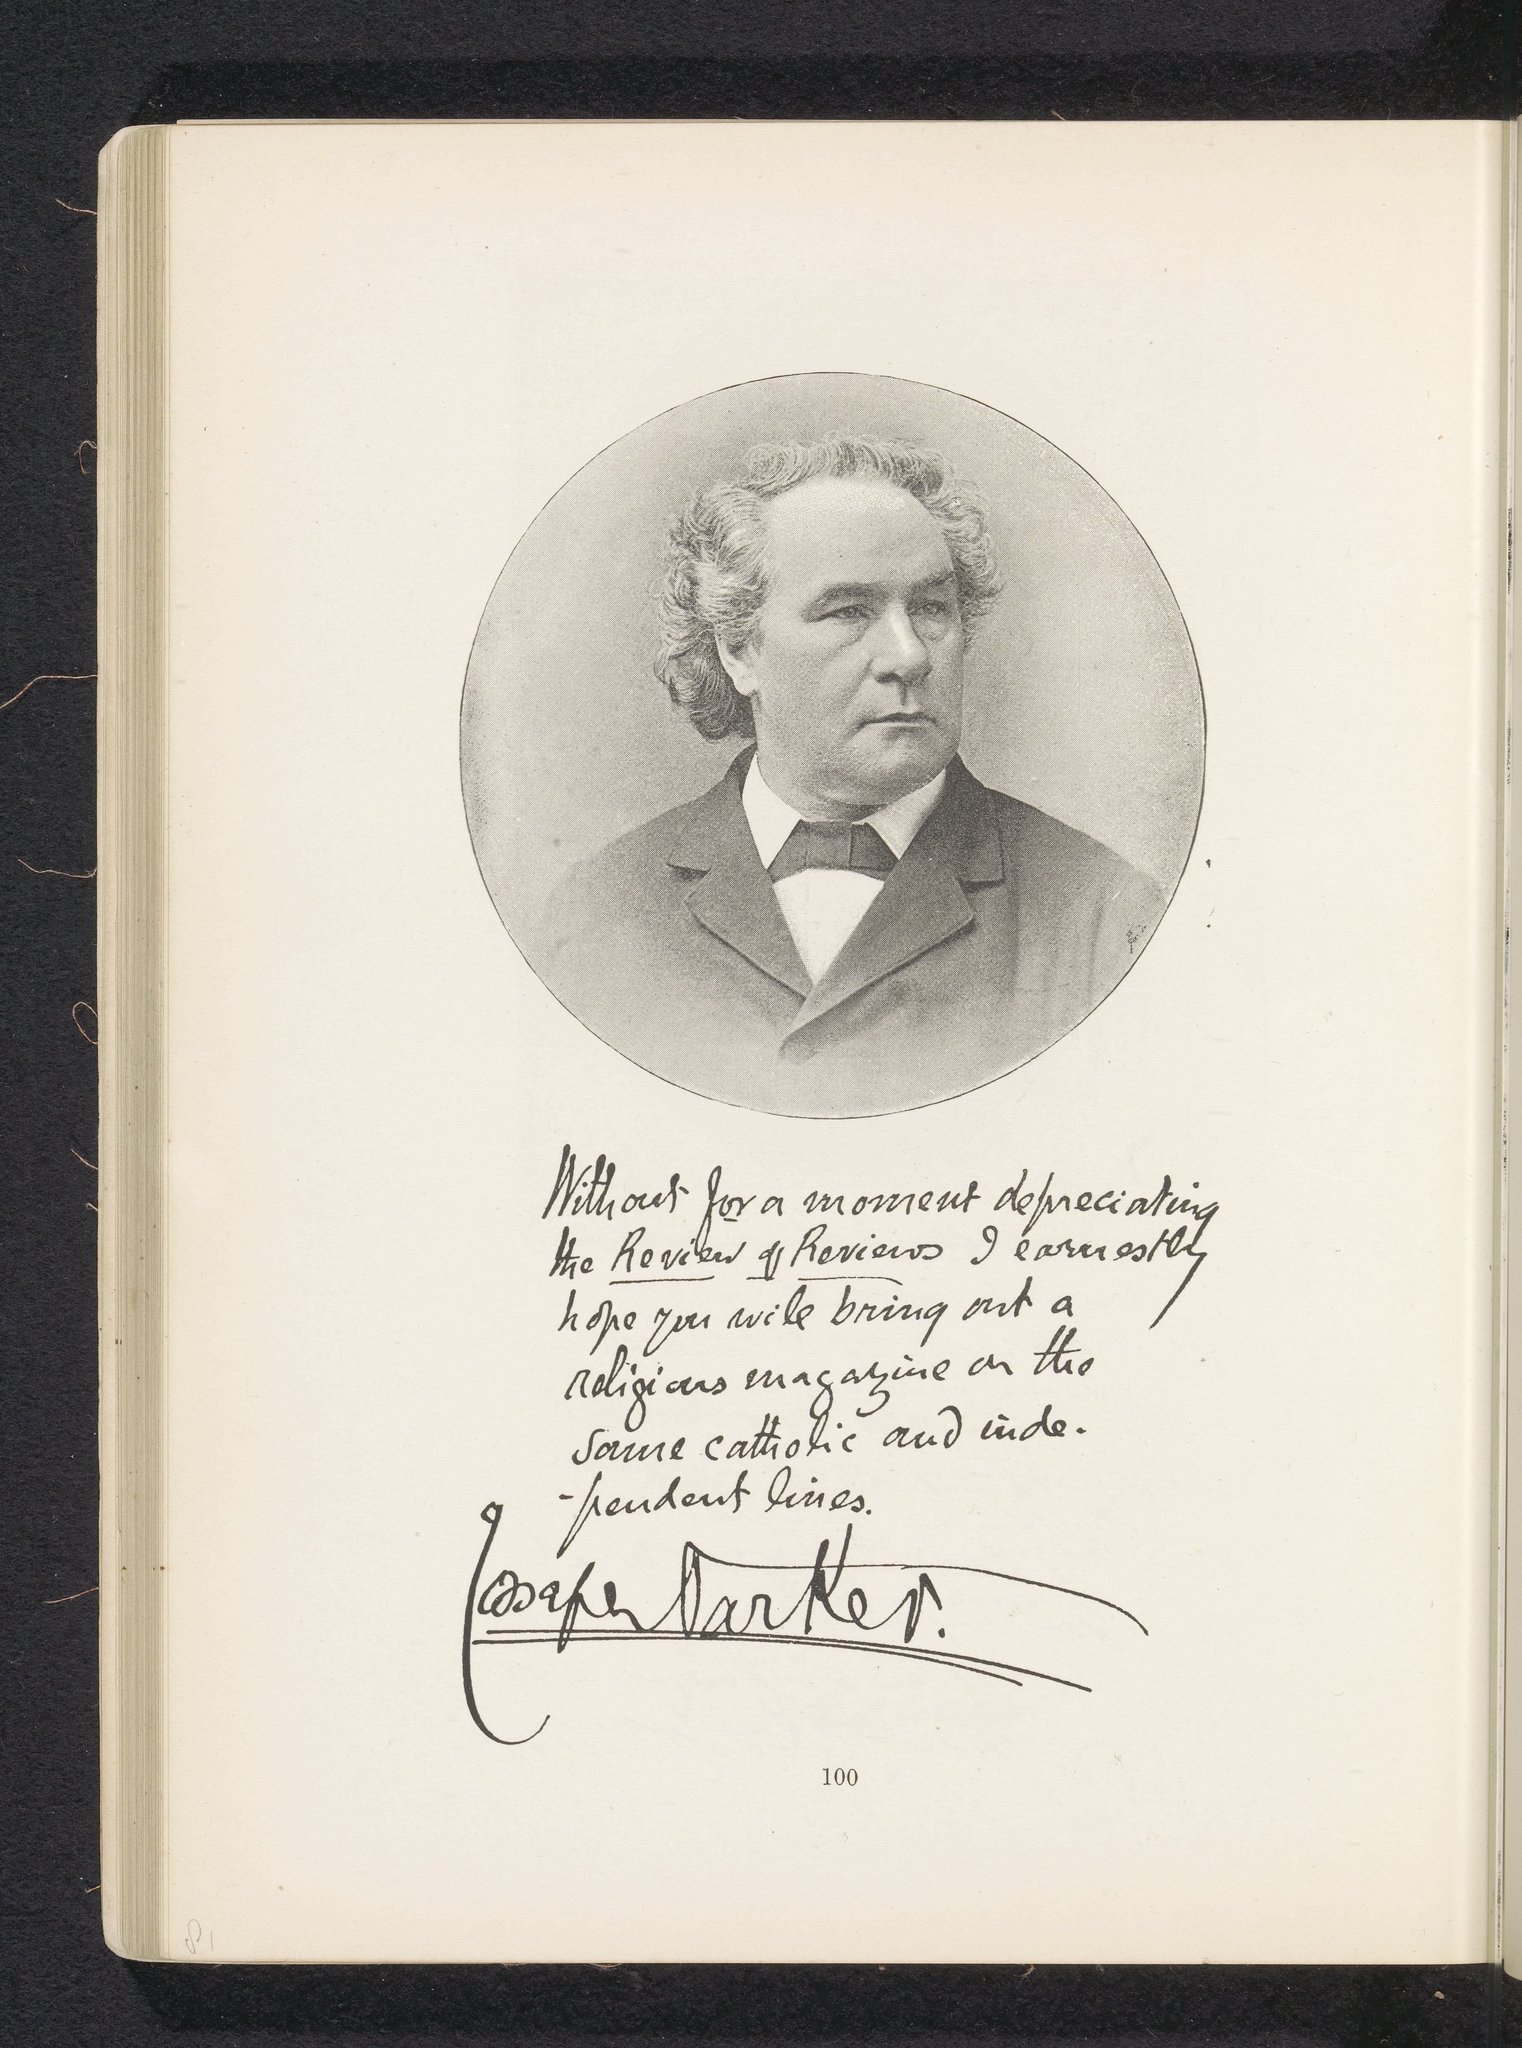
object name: photomechanical print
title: Portret van Joseph Parker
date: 1881-1891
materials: paper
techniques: autotype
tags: theologian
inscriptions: inscription